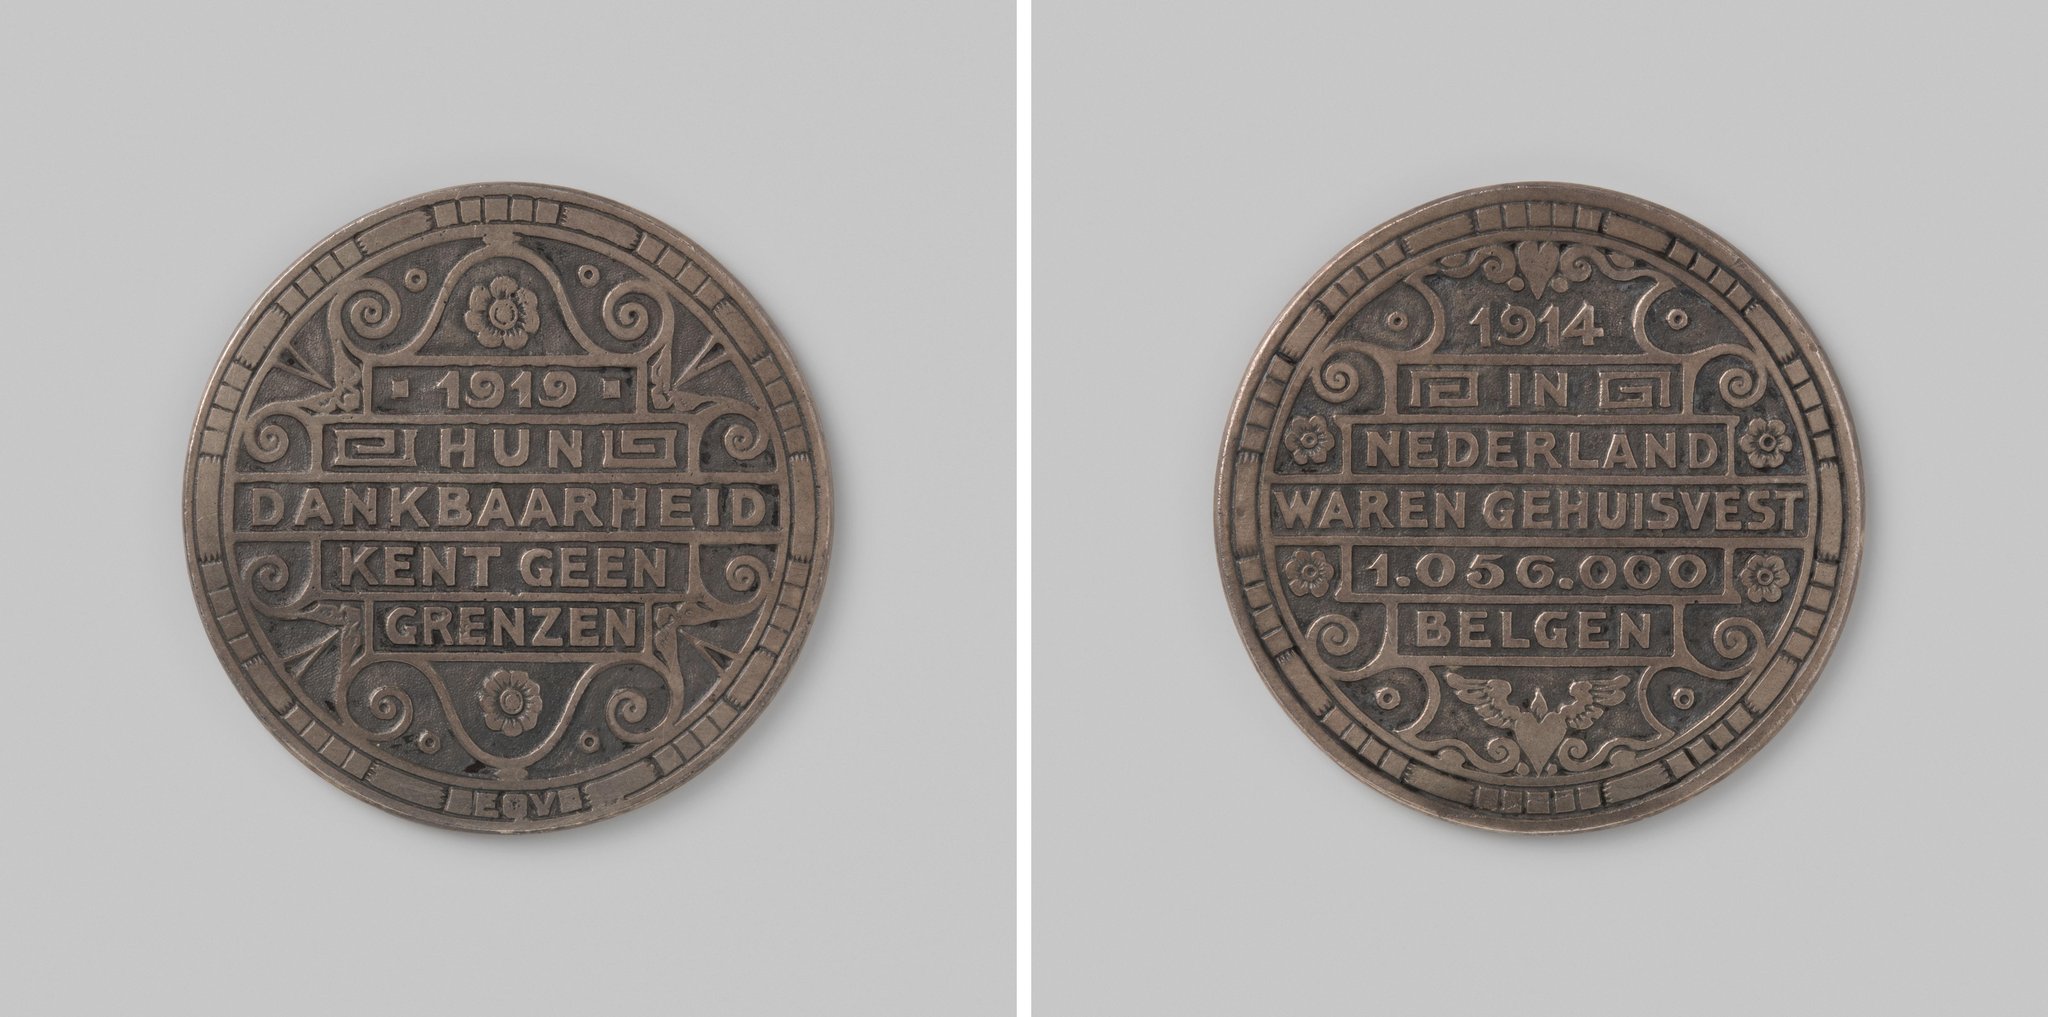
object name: satirical medal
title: Bespotting van de Belgische annexionisten na afloop van de Eerste Wereldoorlog, 1919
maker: elias voet jr.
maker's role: jeweler, print maker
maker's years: 1868-1940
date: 1919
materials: silver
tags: belgium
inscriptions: inscription: ‘1914 / In / Nederland / waren gehuisvest / 1.056.000 / Belgen // 1919 / hun / dankbaarheid / kent geen / grenzen’, signature: ‘E V’